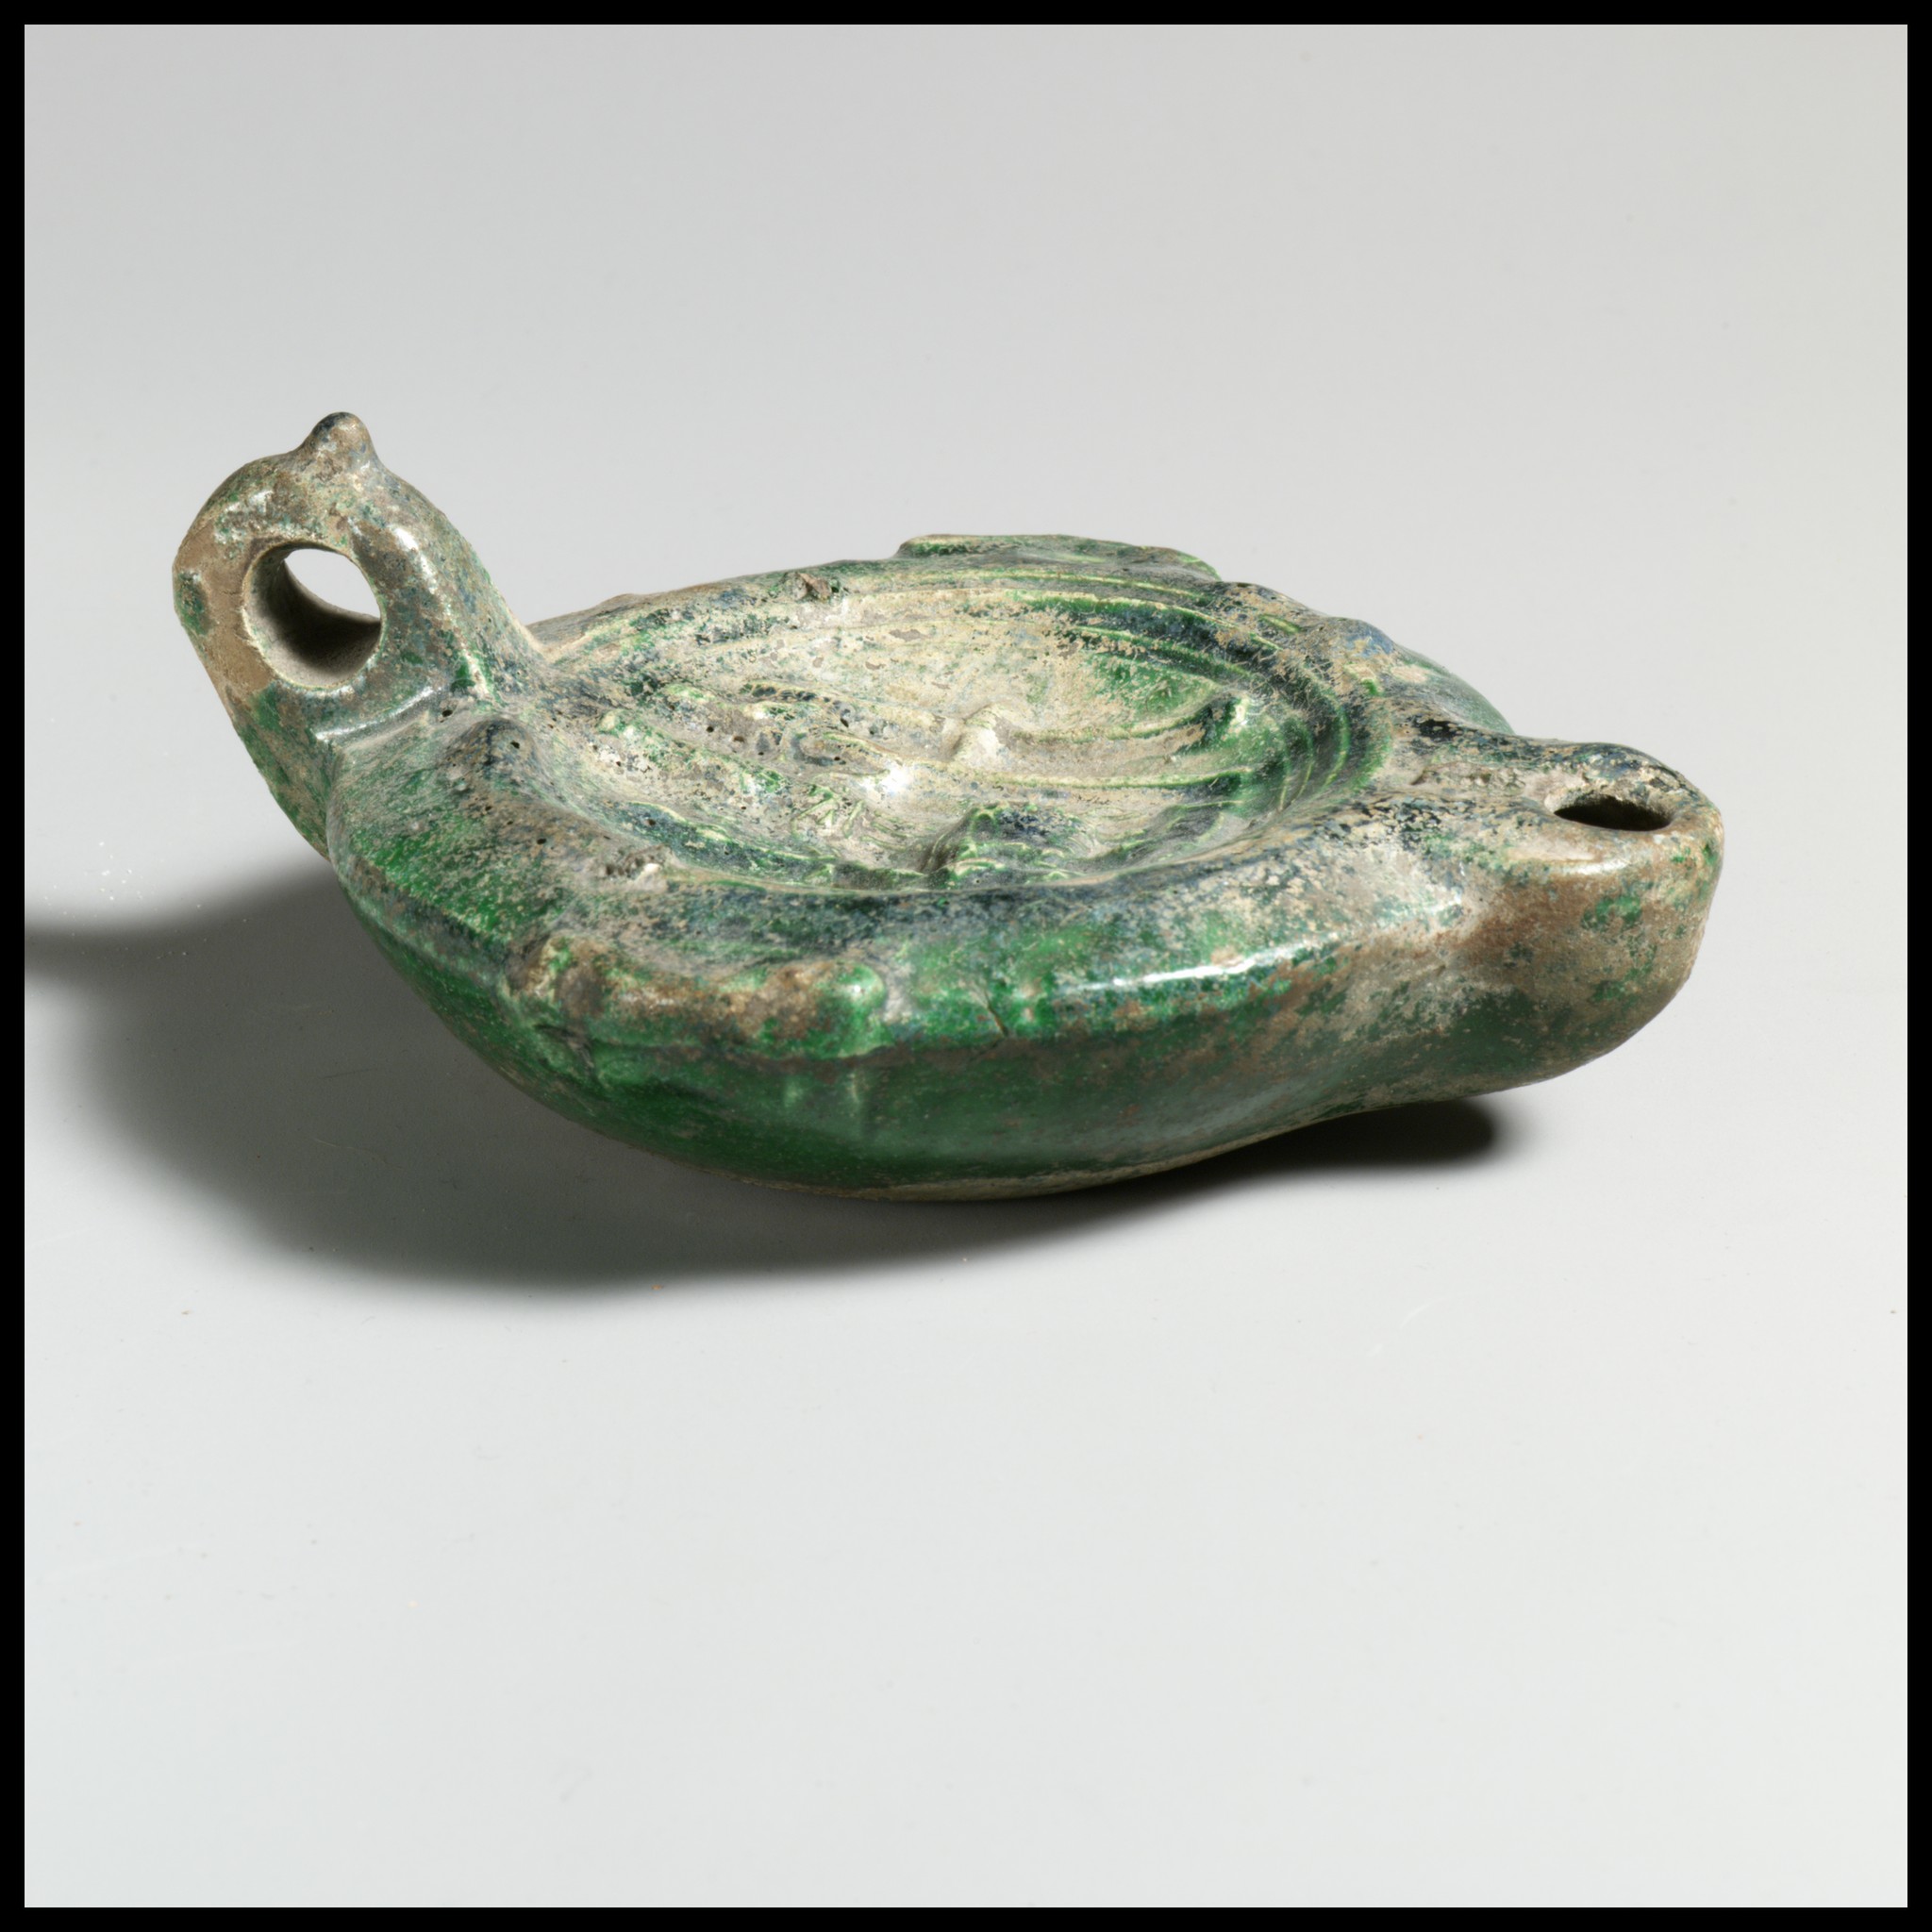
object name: lamp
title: Terracotta lamp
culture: roman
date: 67-200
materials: terracotta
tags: dogs